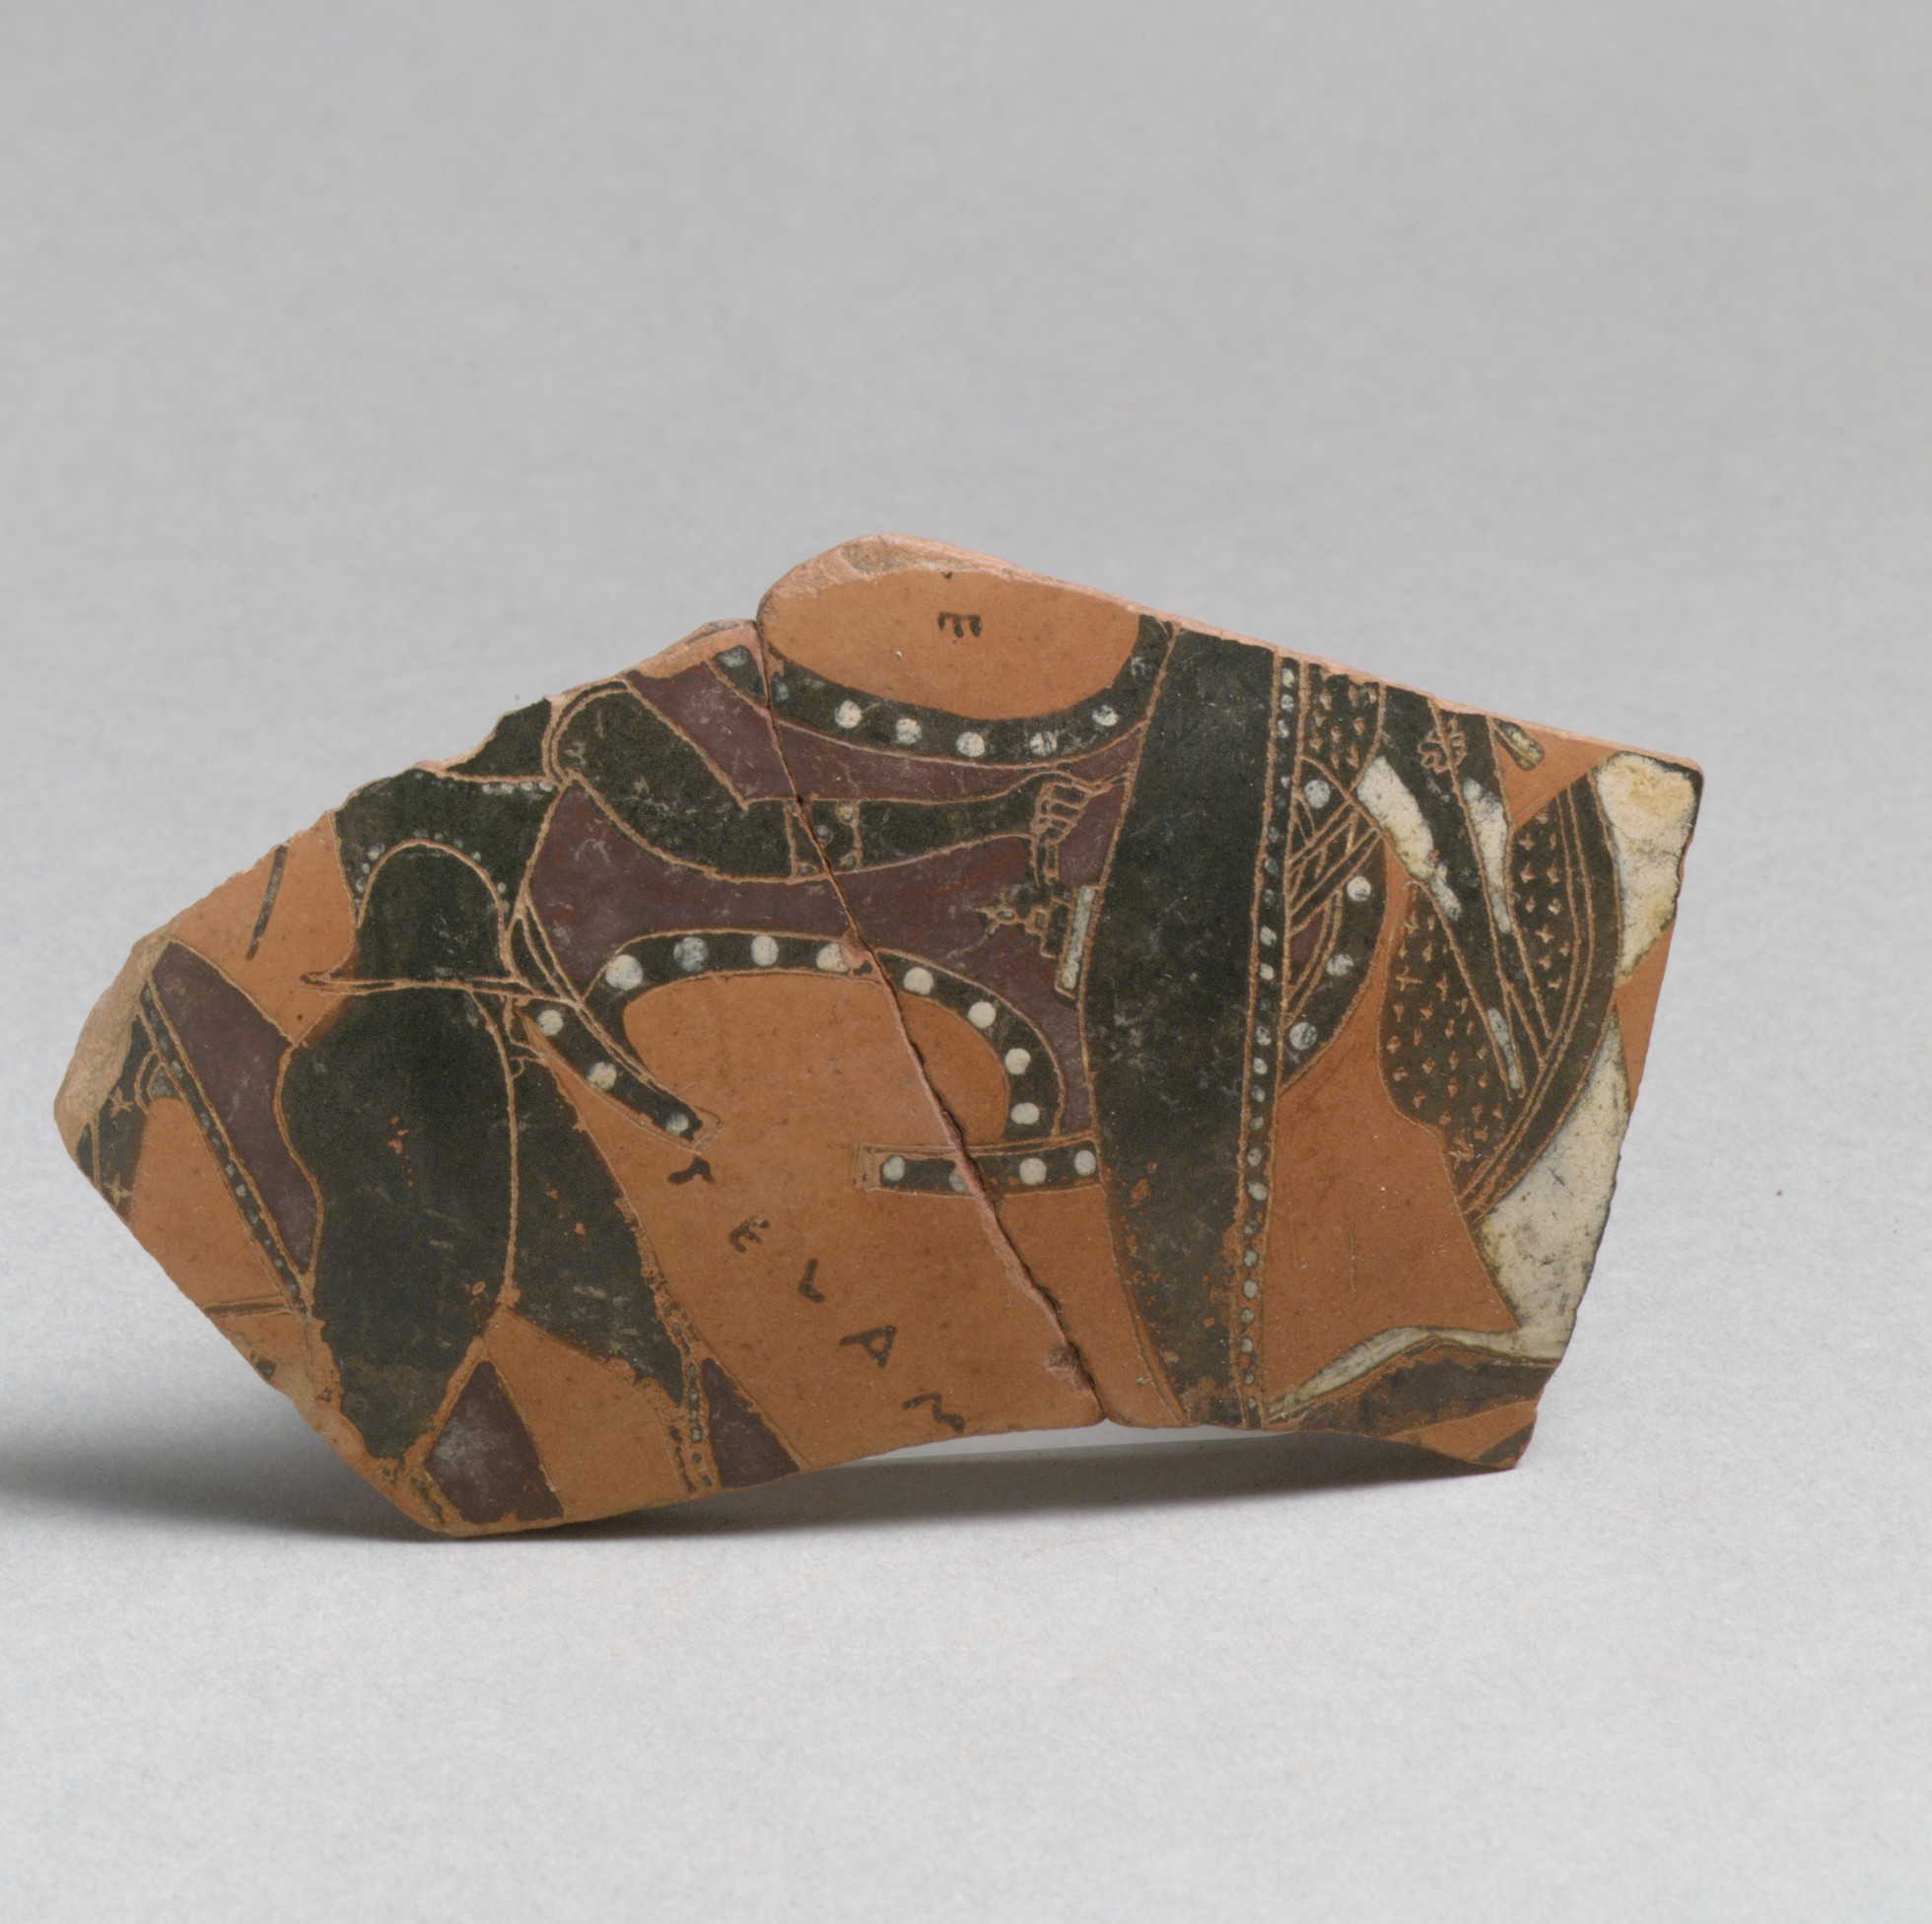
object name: neck amphora, tyrrhenian fragment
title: Neck-amphora, Tyrrhenian fragments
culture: greek, attic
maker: prometheus painter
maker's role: artist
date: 575-550 BCE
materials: terracotta